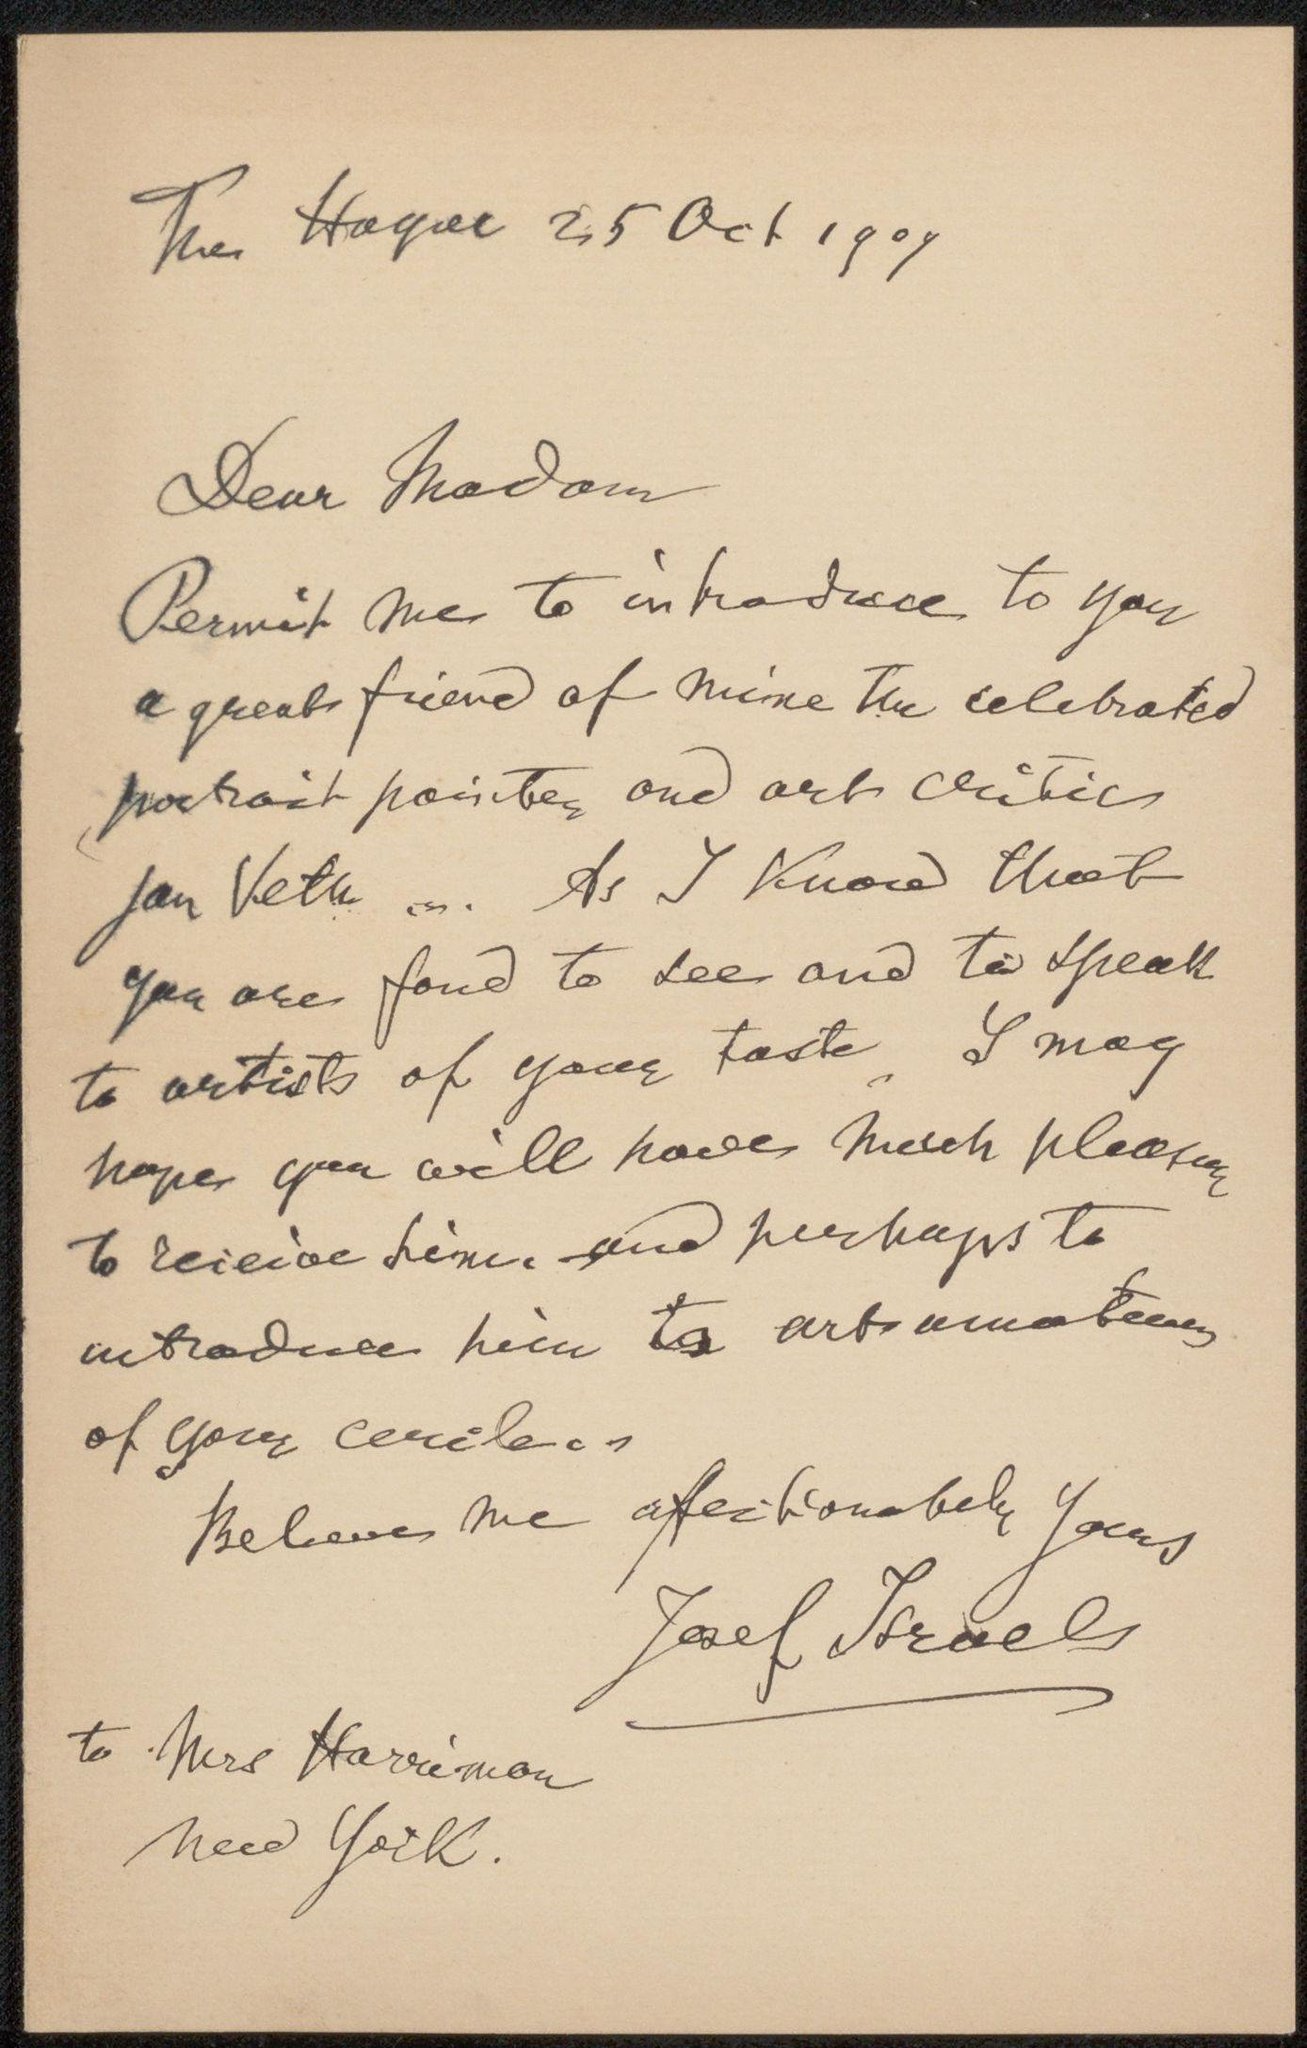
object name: letter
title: Brief aan Mary Williamson Averell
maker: jozef israëls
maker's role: draughtsman, painter, print maker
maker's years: 1824-1911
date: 1909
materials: ink, paper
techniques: pen, writing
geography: the hague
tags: dordrecht, amsterdam, designer, jan veth, historical persons (portraits and scenes from the life)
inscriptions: collector's mark: ‘RPK’, watermark